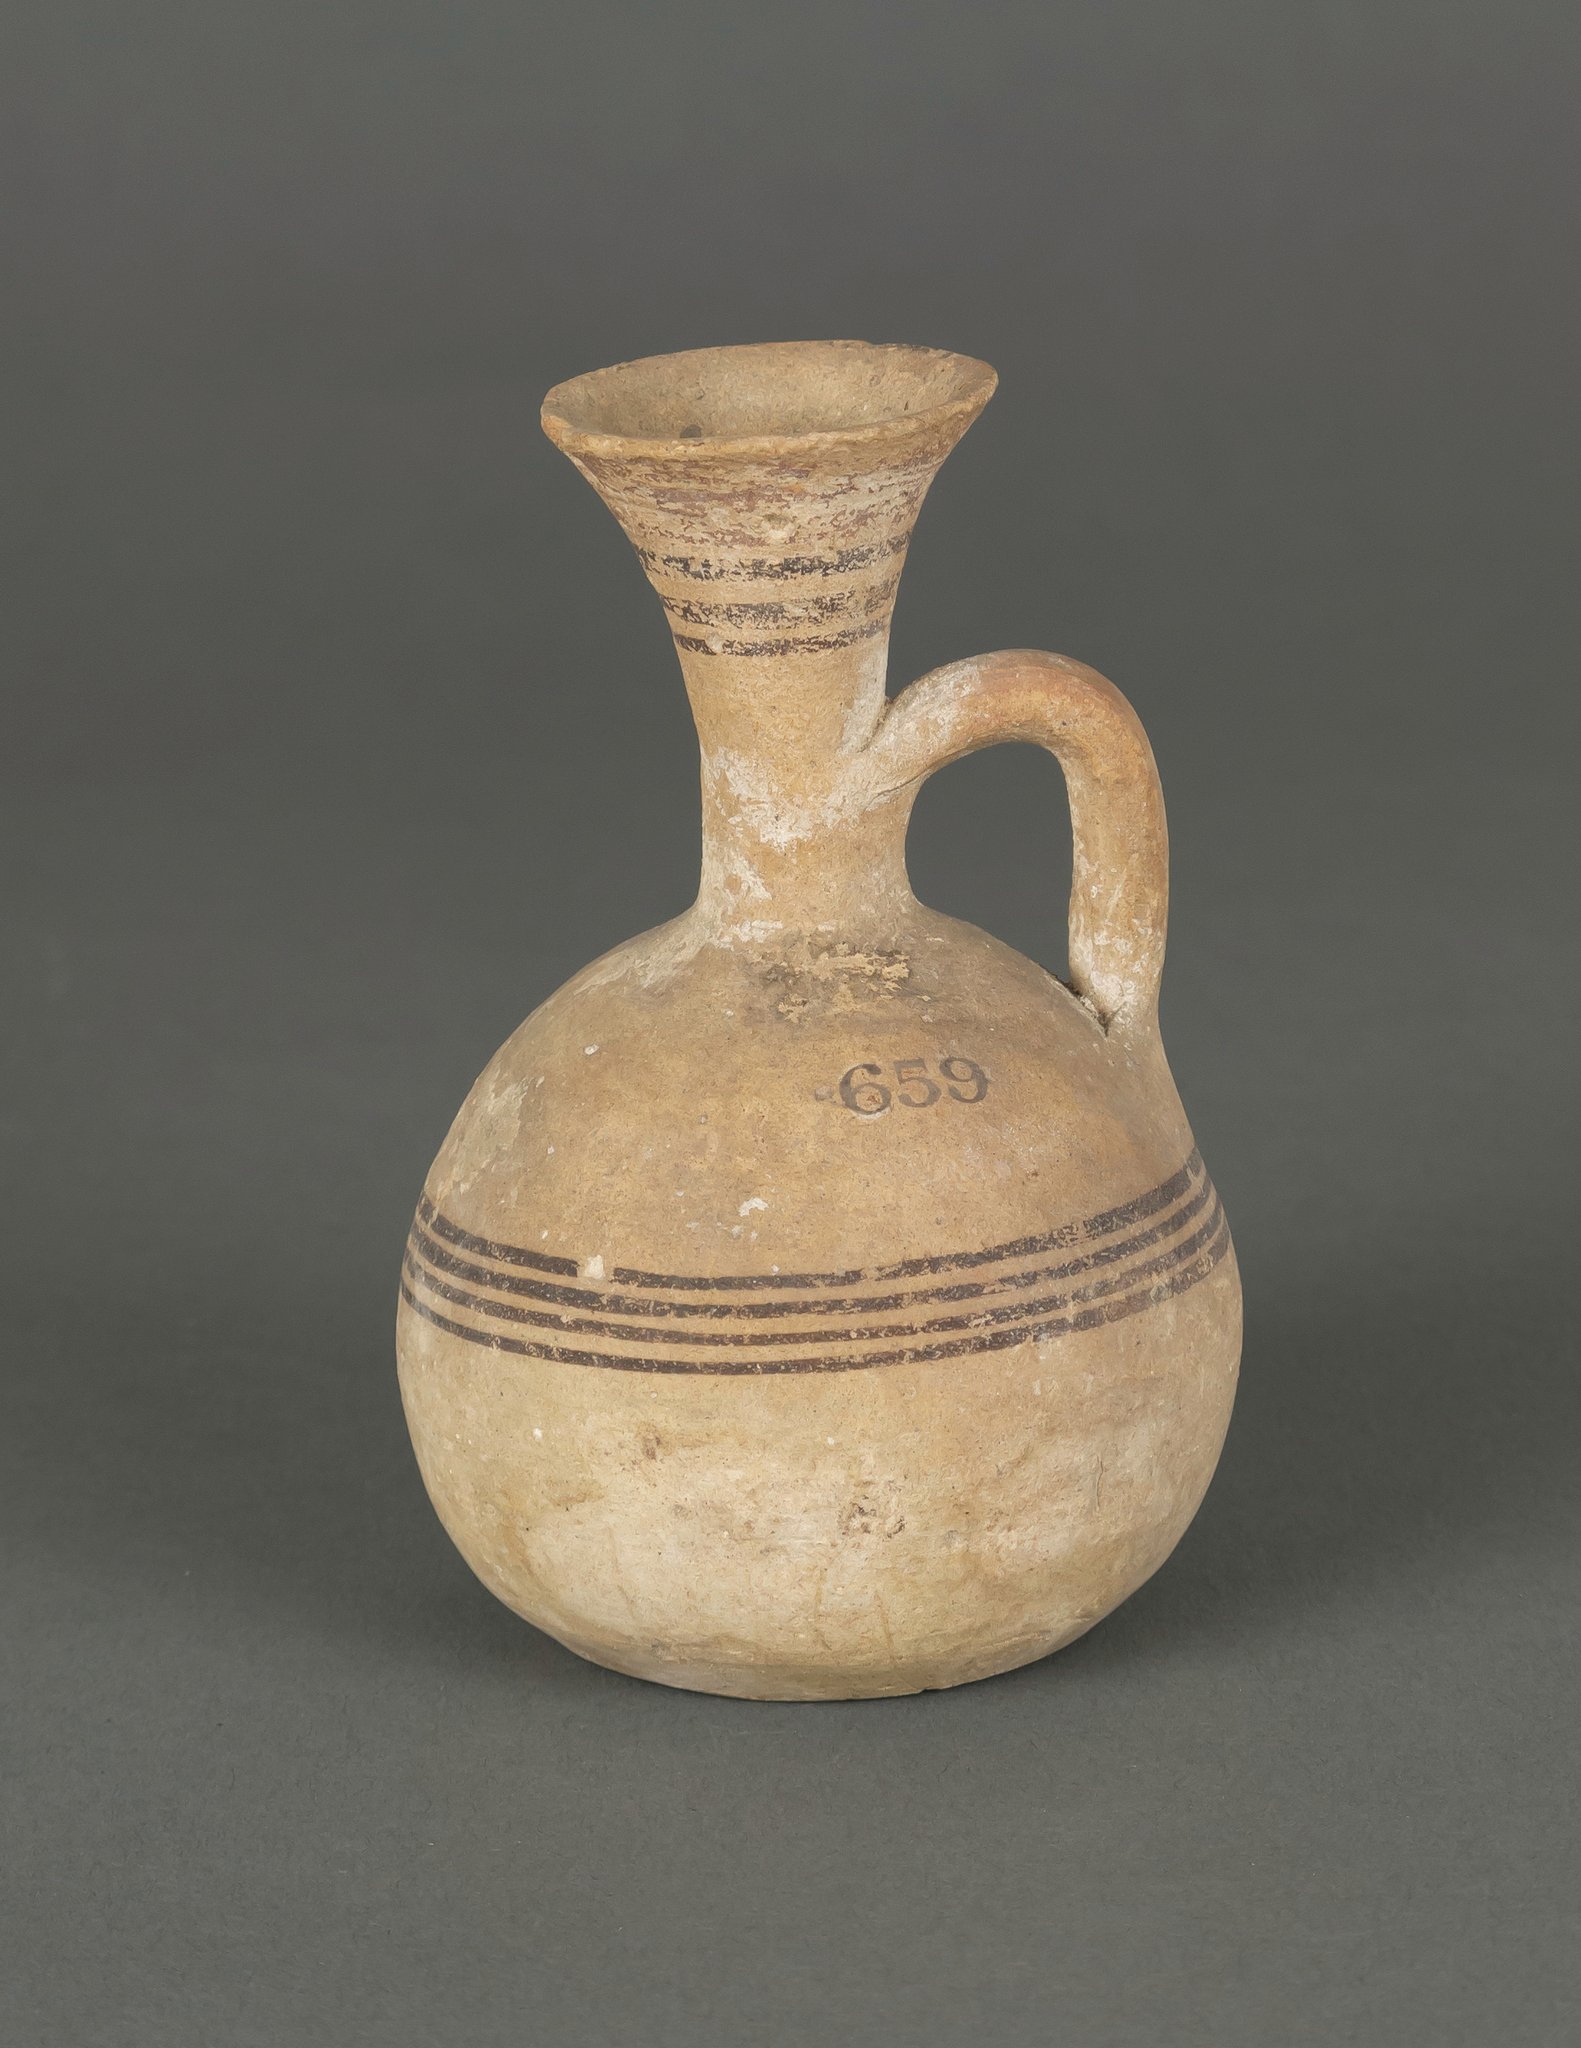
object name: jug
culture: cypriot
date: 1050-900 BCE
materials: terracotta